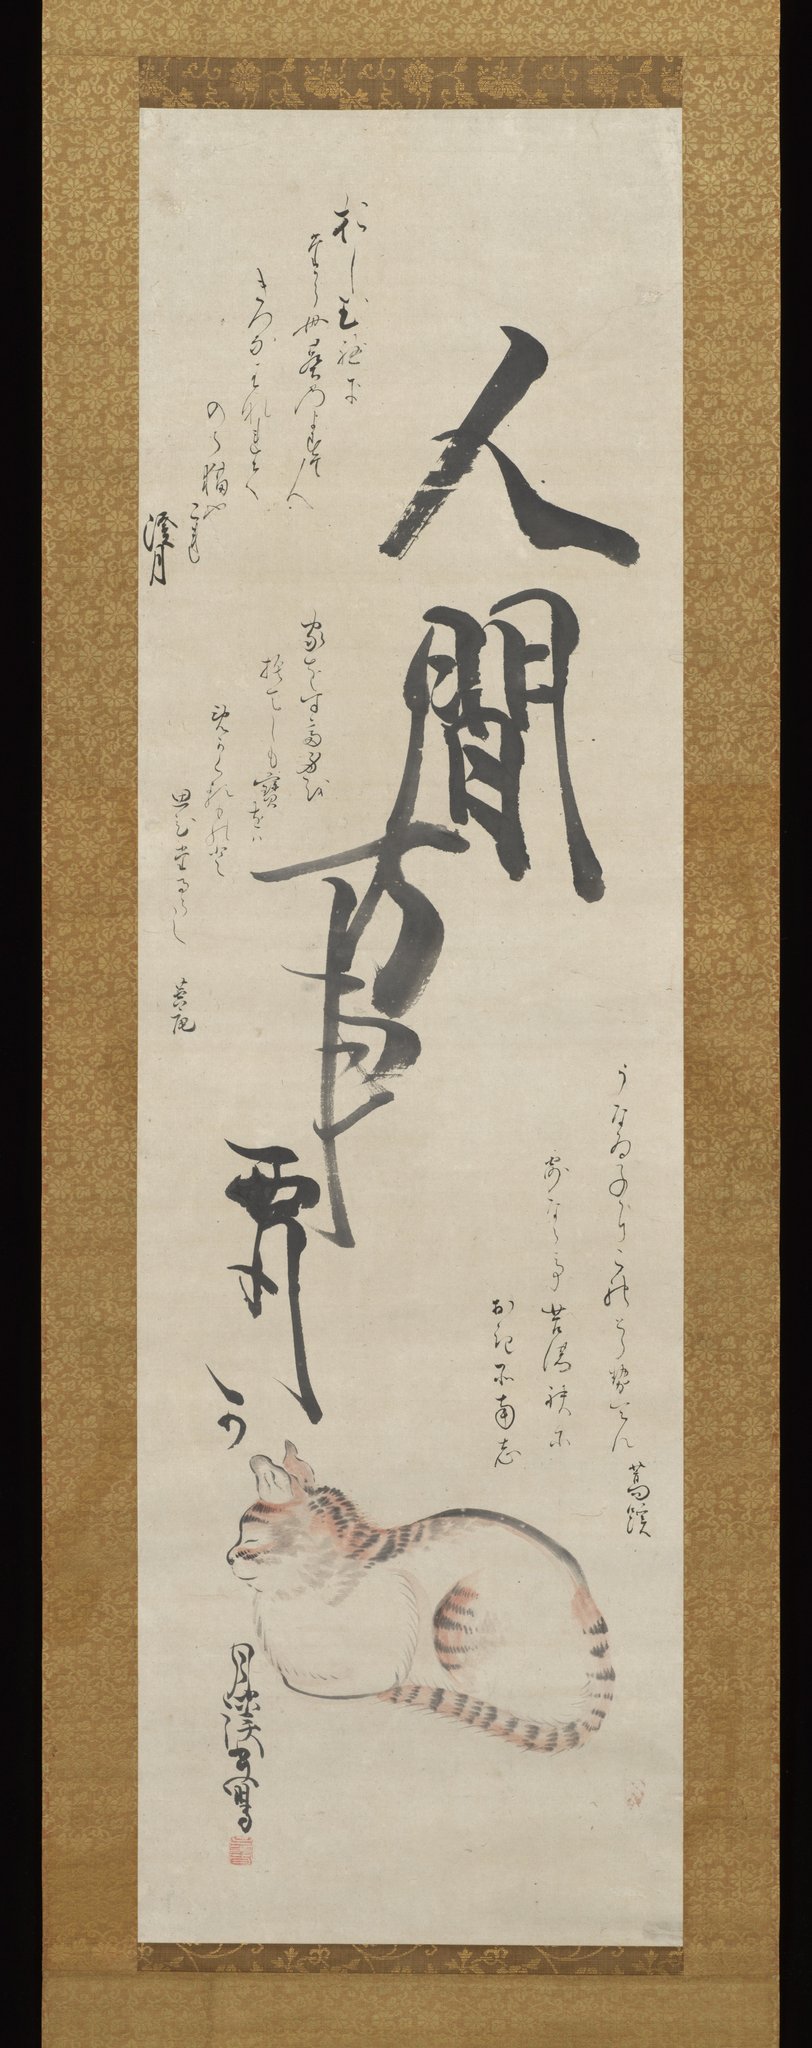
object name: hanging scroll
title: Cat with Poems: Pictorial Parody of Priest Saigyo's Legend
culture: japanese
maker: matsumura goshun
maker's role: artist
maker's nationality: japanese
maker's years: 1752-1811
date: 1701-1800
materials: ink, paper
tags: poetry,cats